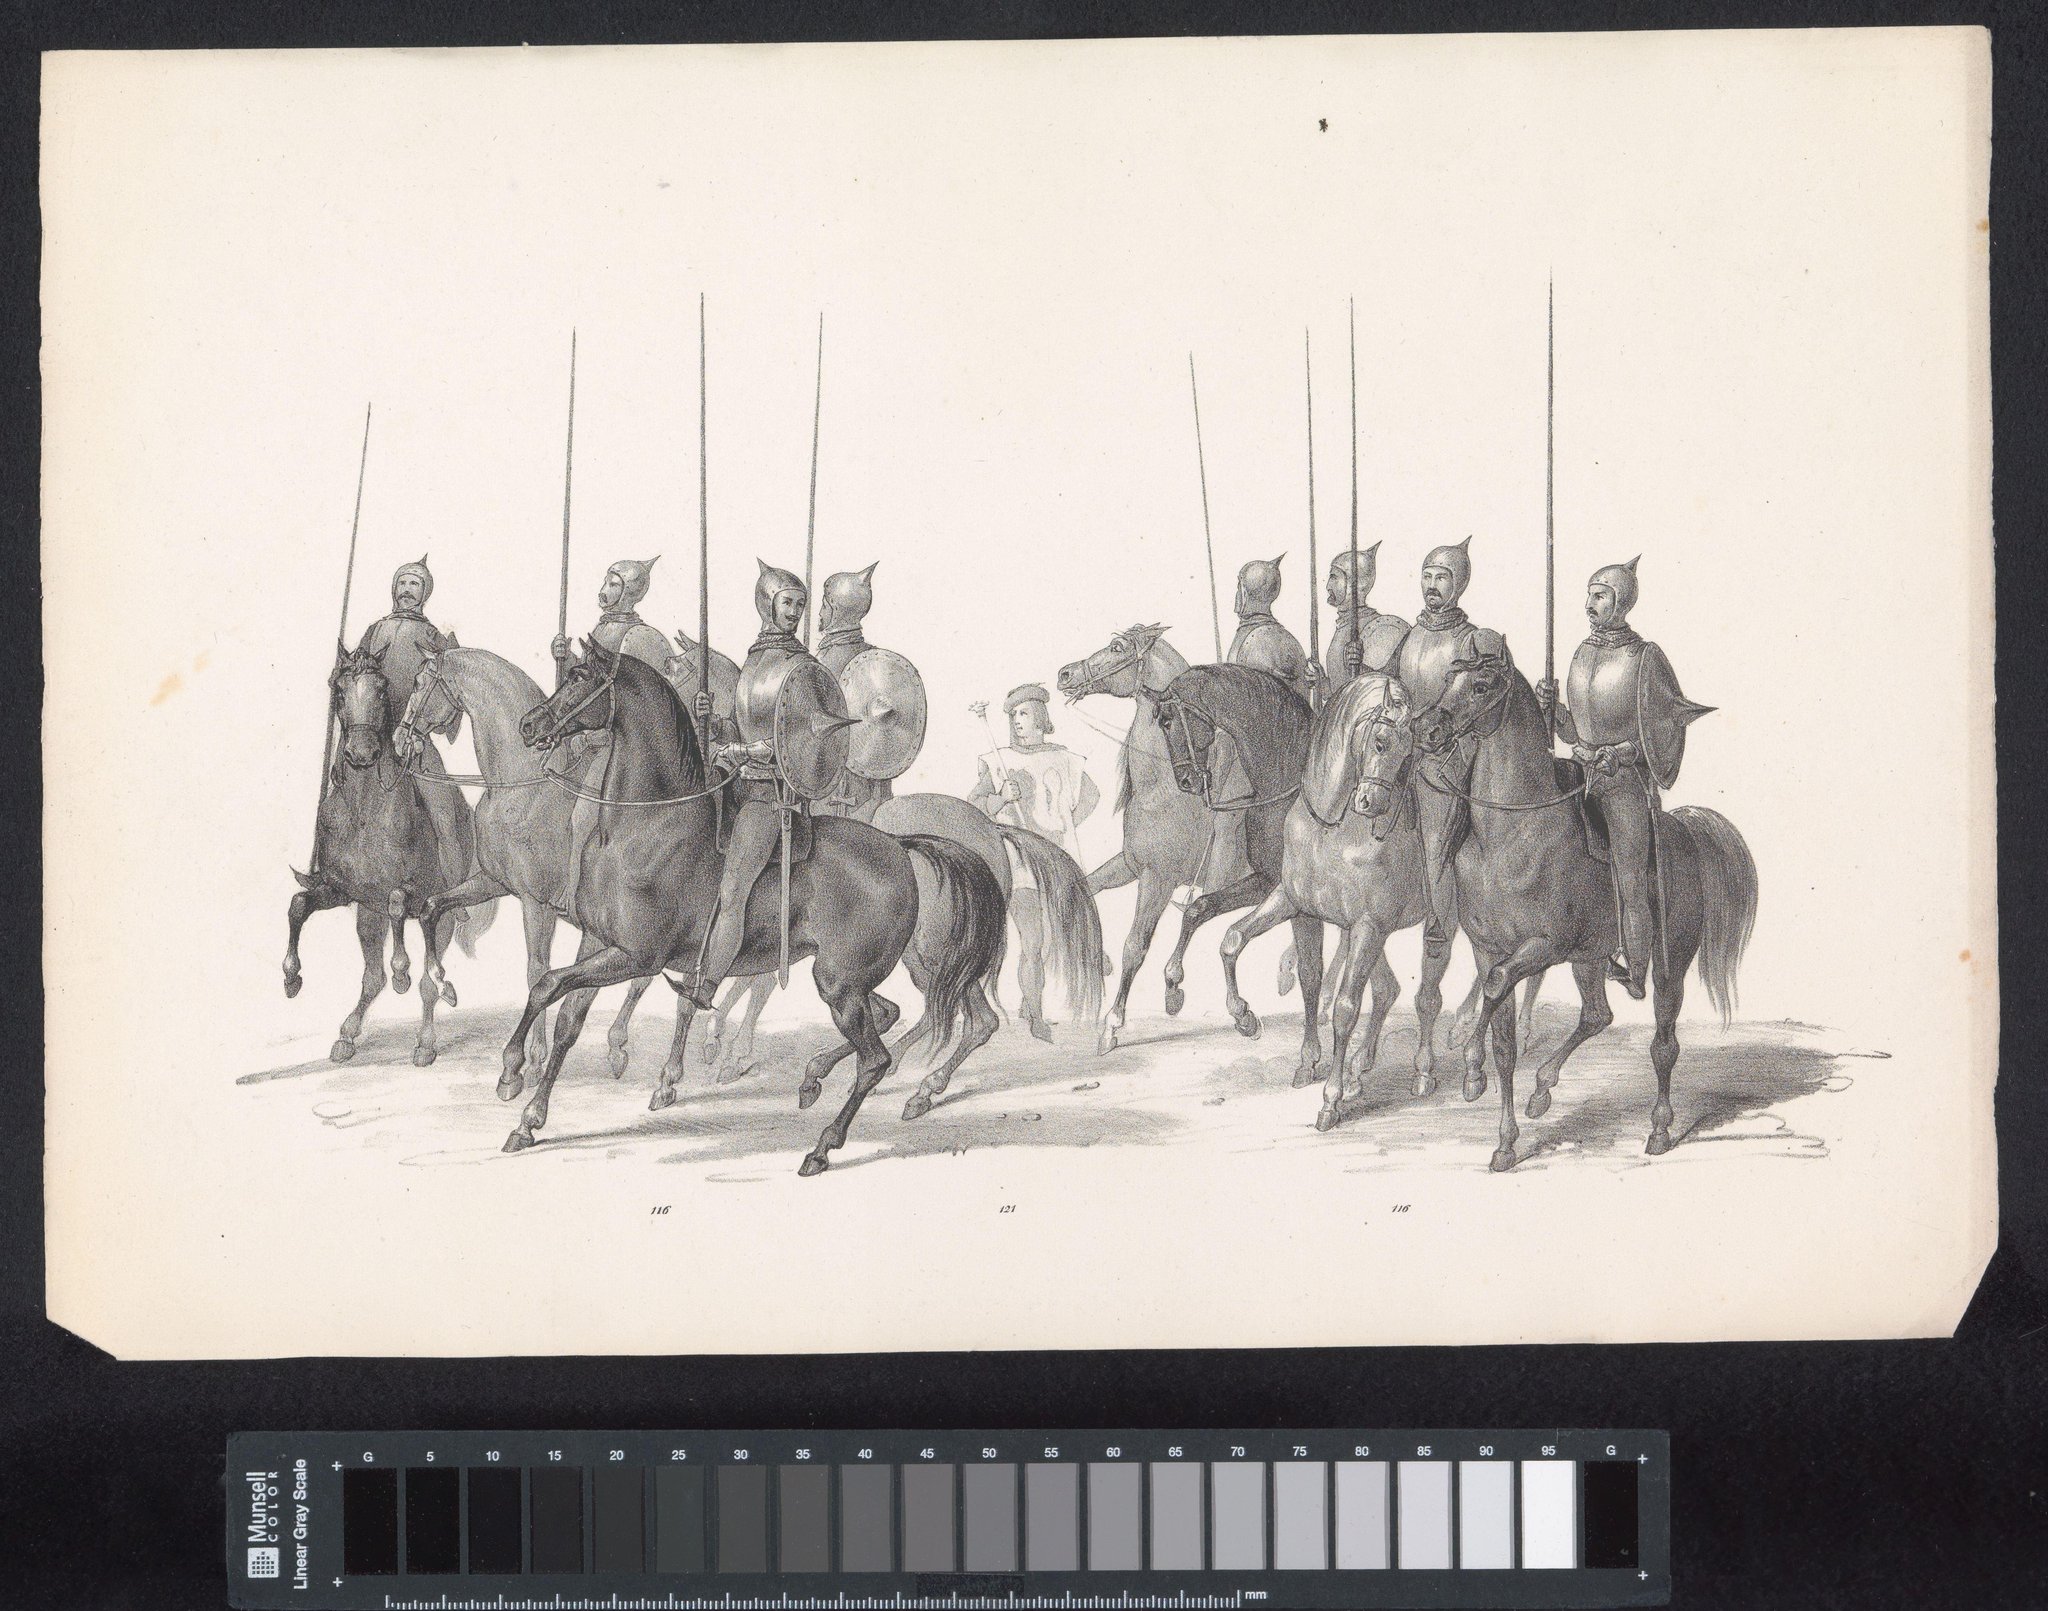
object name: print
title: Maskerade door studenten van de Leidse Hogeschool, 1840 (plaat 19)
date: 1840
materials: paper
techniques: lithograph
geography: leiden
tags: jan van beieren, students' pageant, costumes used in pageants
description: Historische gekostumeerde optocht van de studenten van de Hogeschool van Leiden op 8 februari 1840. De optocht verbeeldt de intocht van hertog Jan van Beieren te Leiden op 18 augustus 1420. Negentiende plaat in een serie van negentien ongenummerde platen, met de groepen genummerd 116-121.